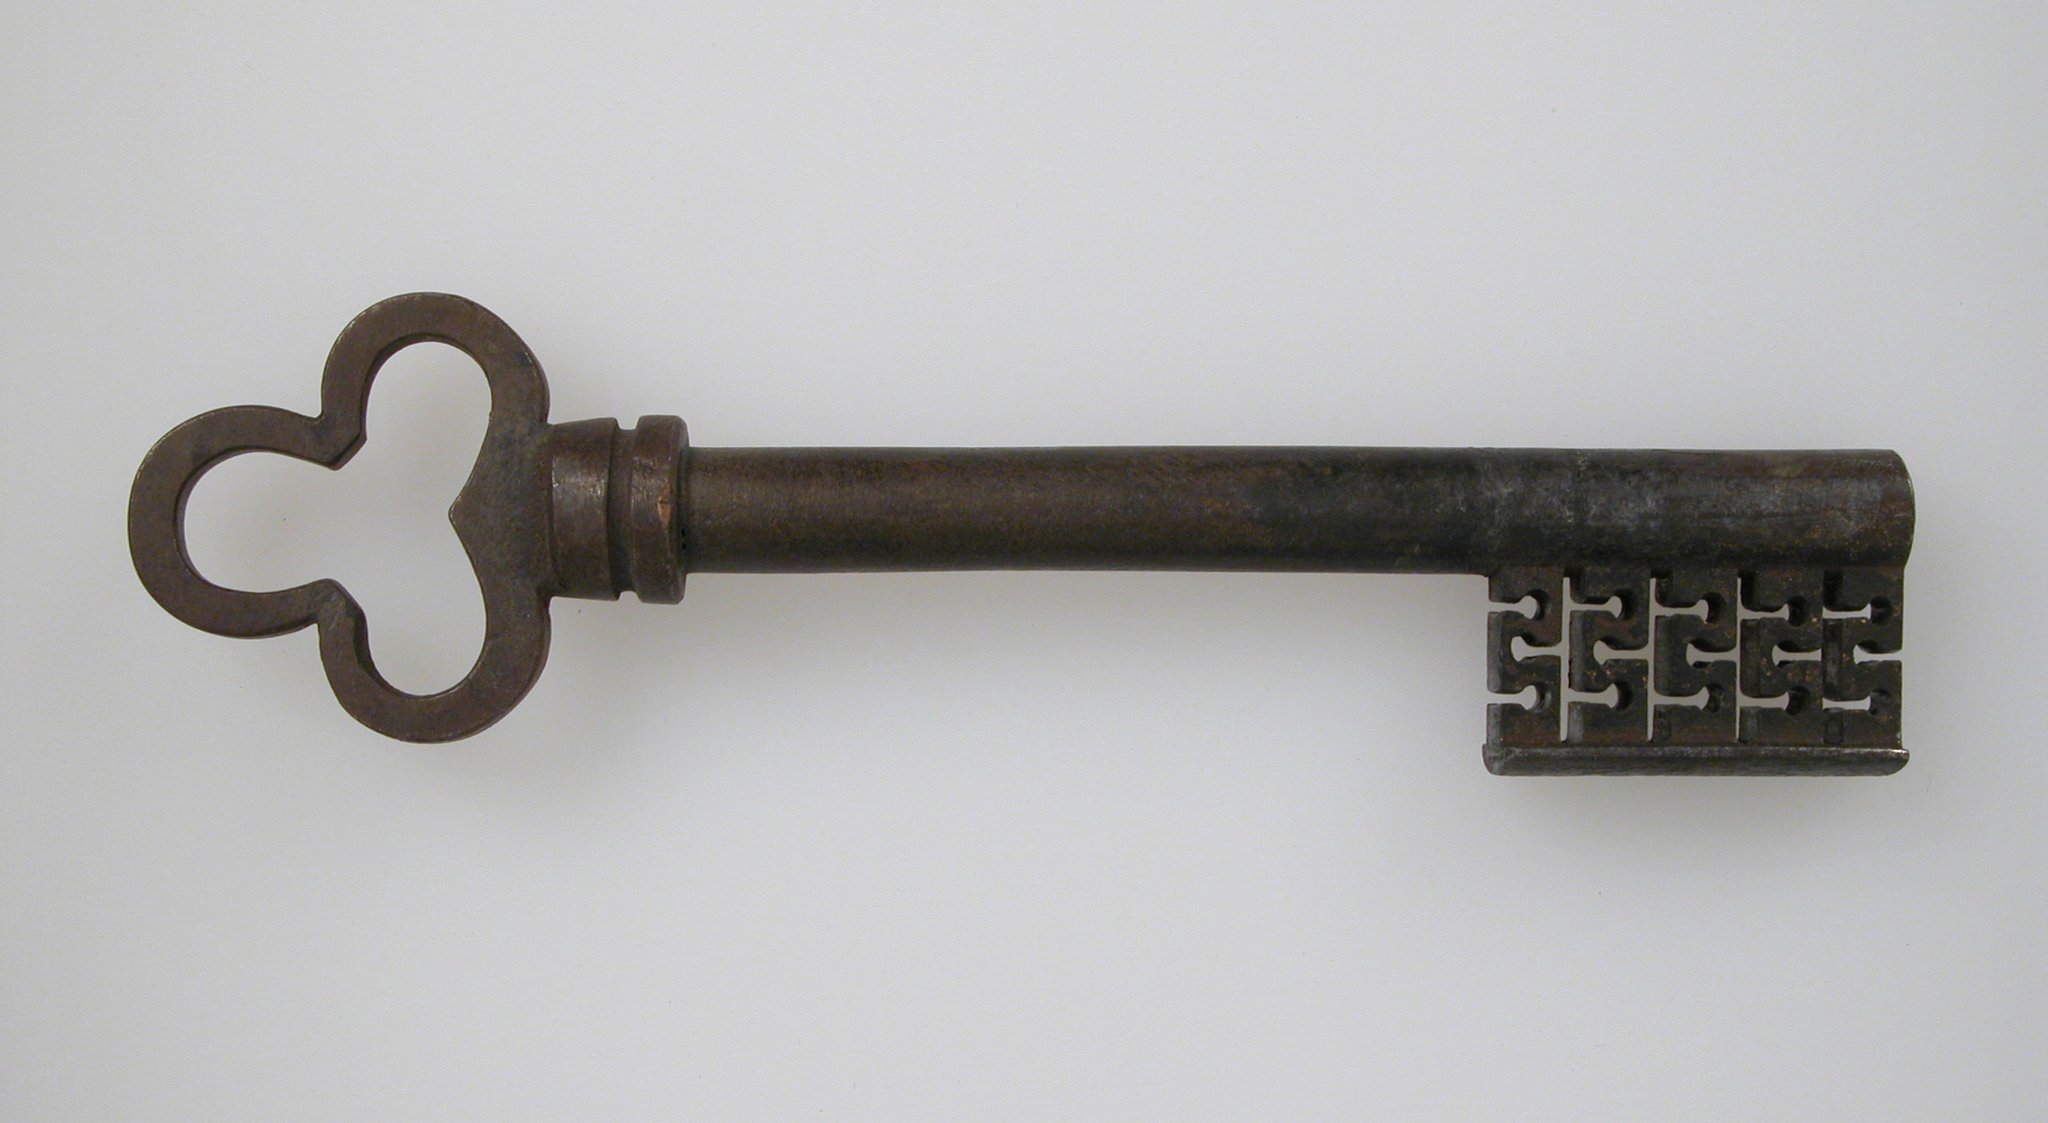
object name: key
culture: german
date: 1451-1500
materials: iron